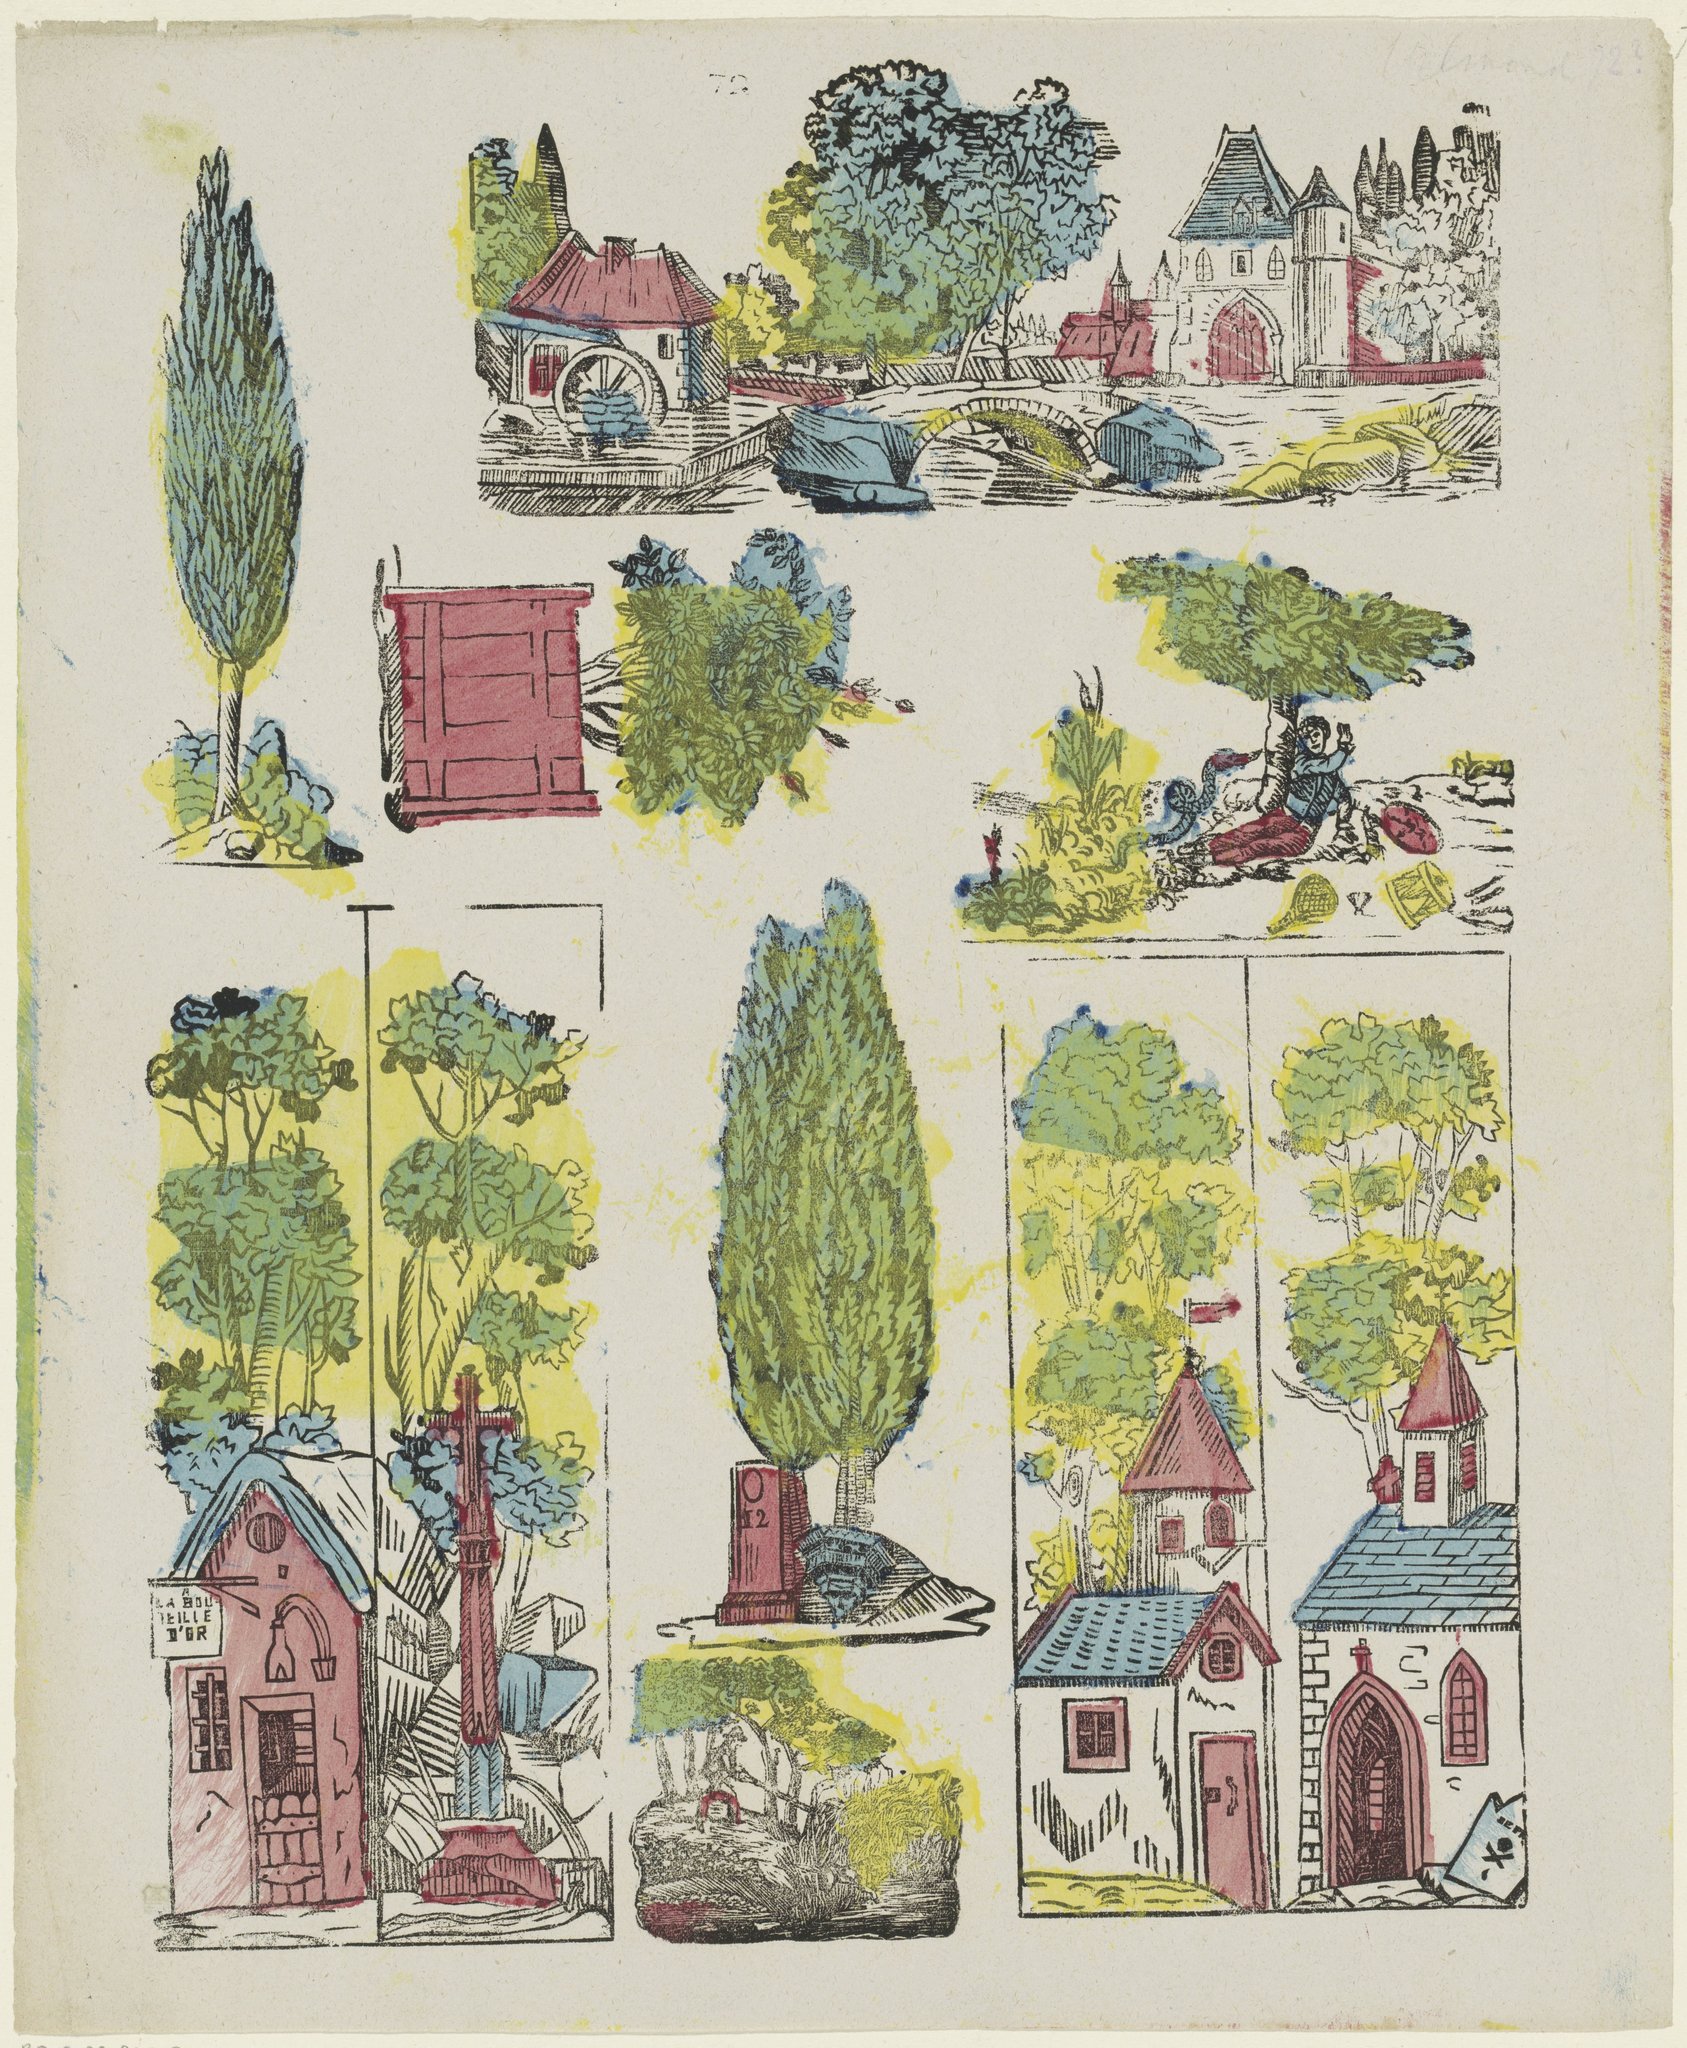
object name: print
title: Om uit te knippen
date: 1827-1894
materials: paper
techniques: colour, letterpress printing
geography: schaarbeek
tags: trees, stage design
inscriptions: collector's mark: Lugt 2760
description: Blad met 10 voorstellingen van bomen, gebouwen en landschappen om uit te knippen (toneelschermen). Genummerd midden boven: 70.